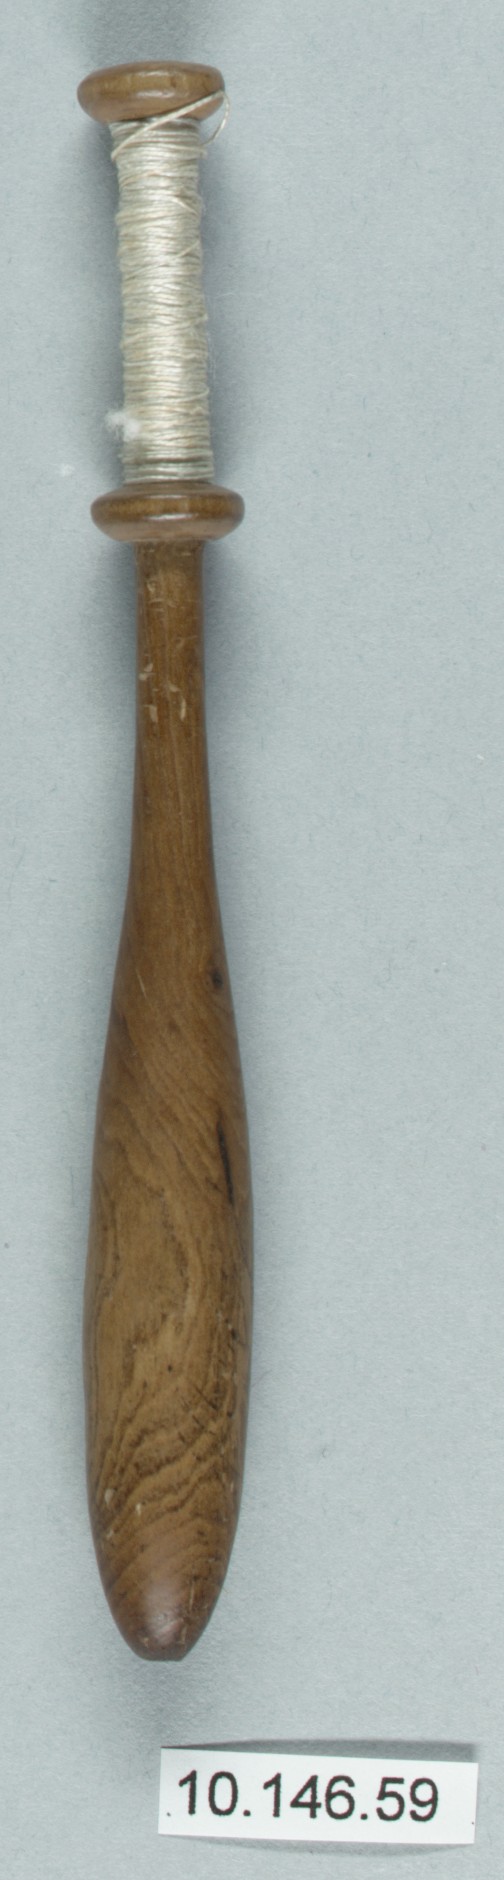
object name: bobbin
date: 1701-1800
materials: wood